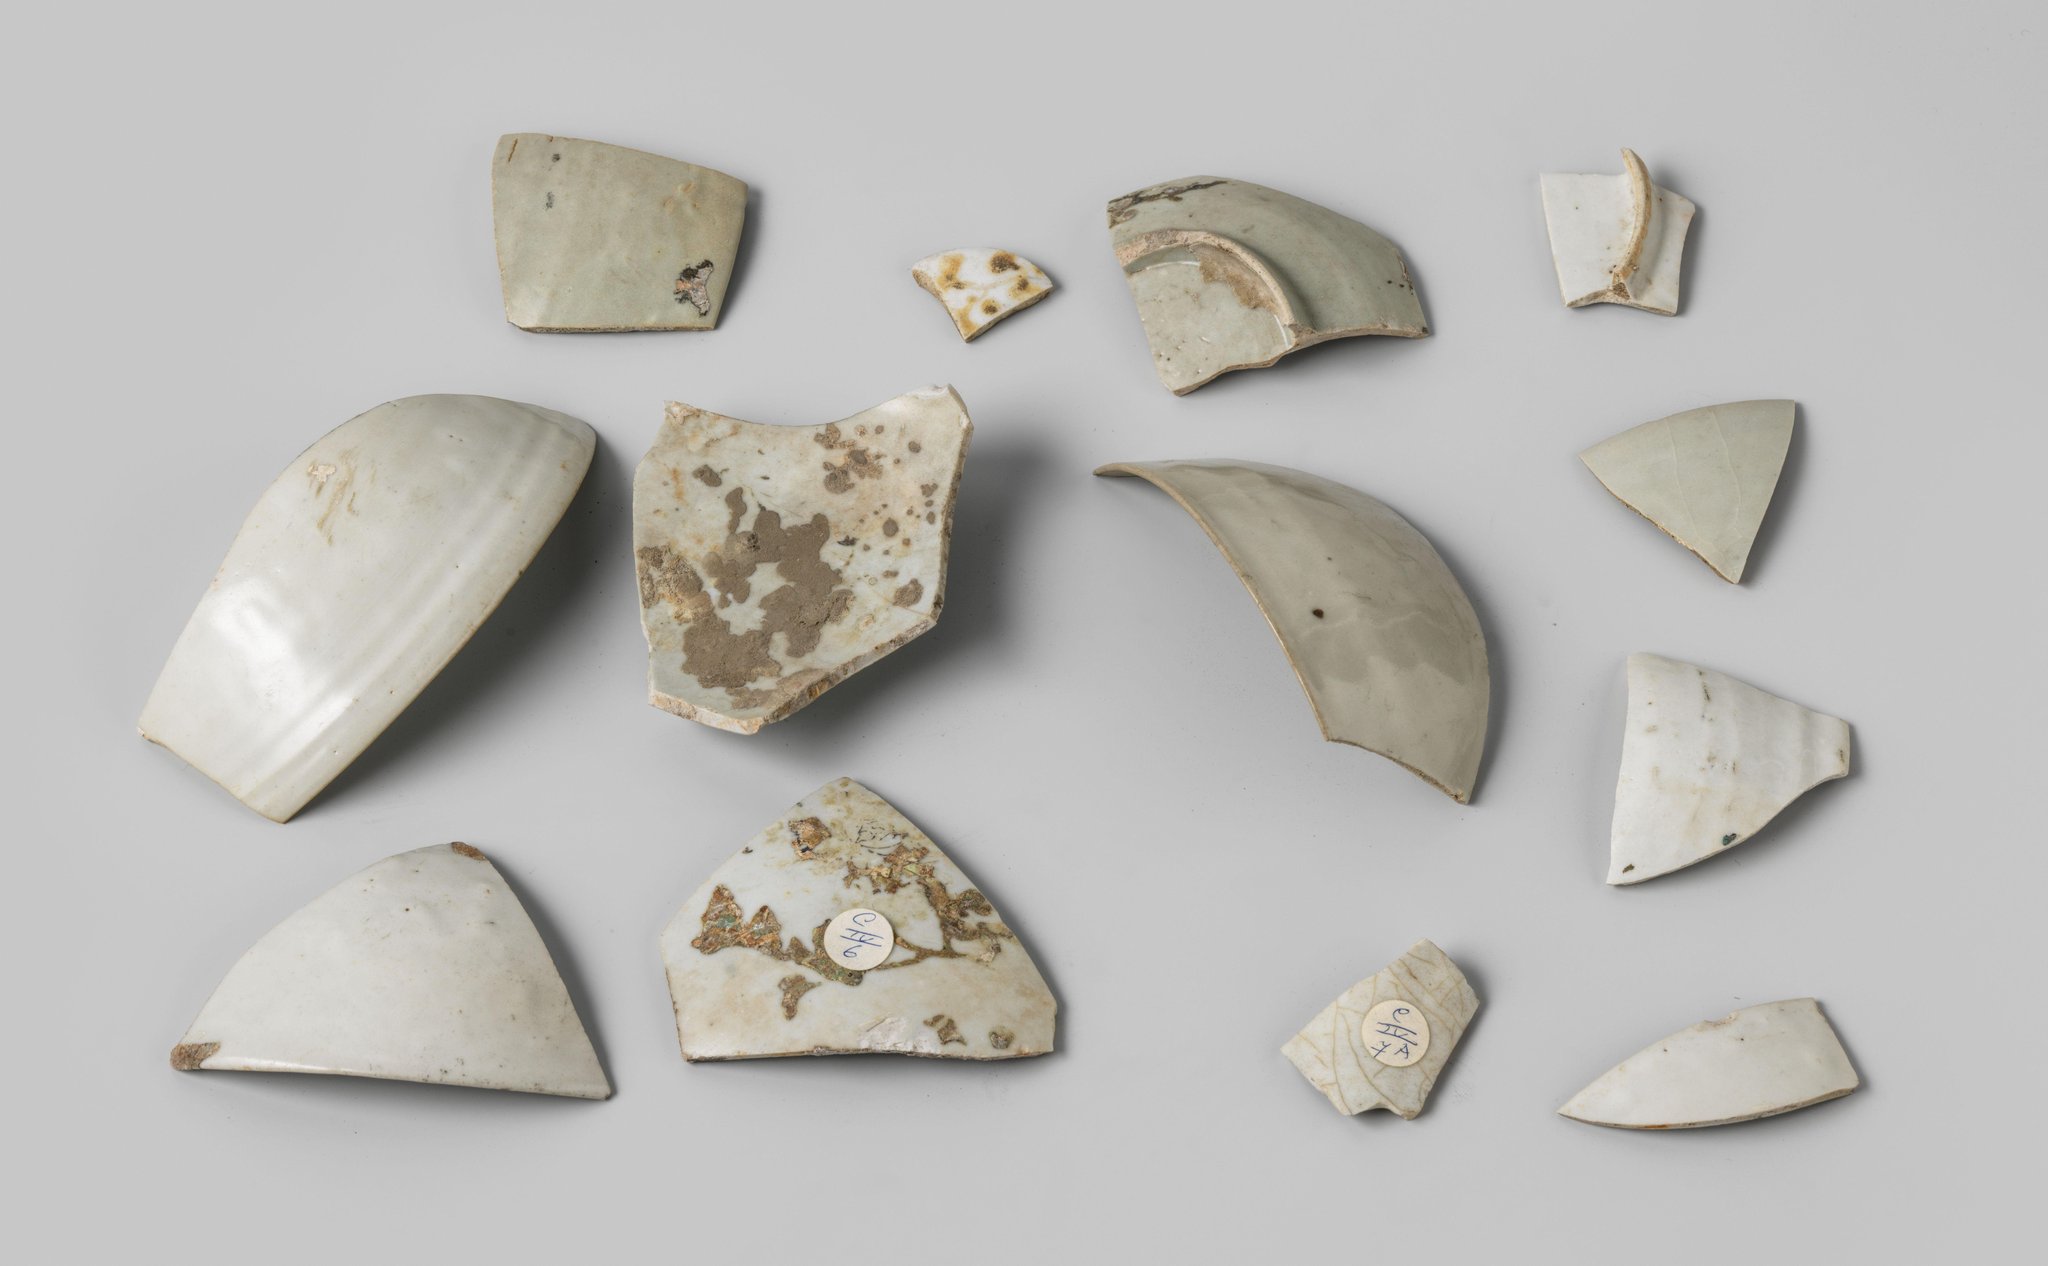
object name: plate dish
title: Scherven van bord, gevonden bij V.O.C.-schip Witte Leeuw, mogelijk afkomstig van Zeelelie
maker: Anonymous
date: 1775-1800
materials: porcelain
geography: jingdezhen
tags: verenigde oostindische compagnie, sint-helena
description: Scherven van borden gemaakt voor export naar Anglo-Saxische landen, Nanking-ceramiek bord. Dit object is 18e-eeuws en kan dus niet van de vracht van de Witte Leeuw zijn. Onduidelijk is of het object van de site komt of dat het later is vermengd, mogelijk met materiaal van de Zeelelie.